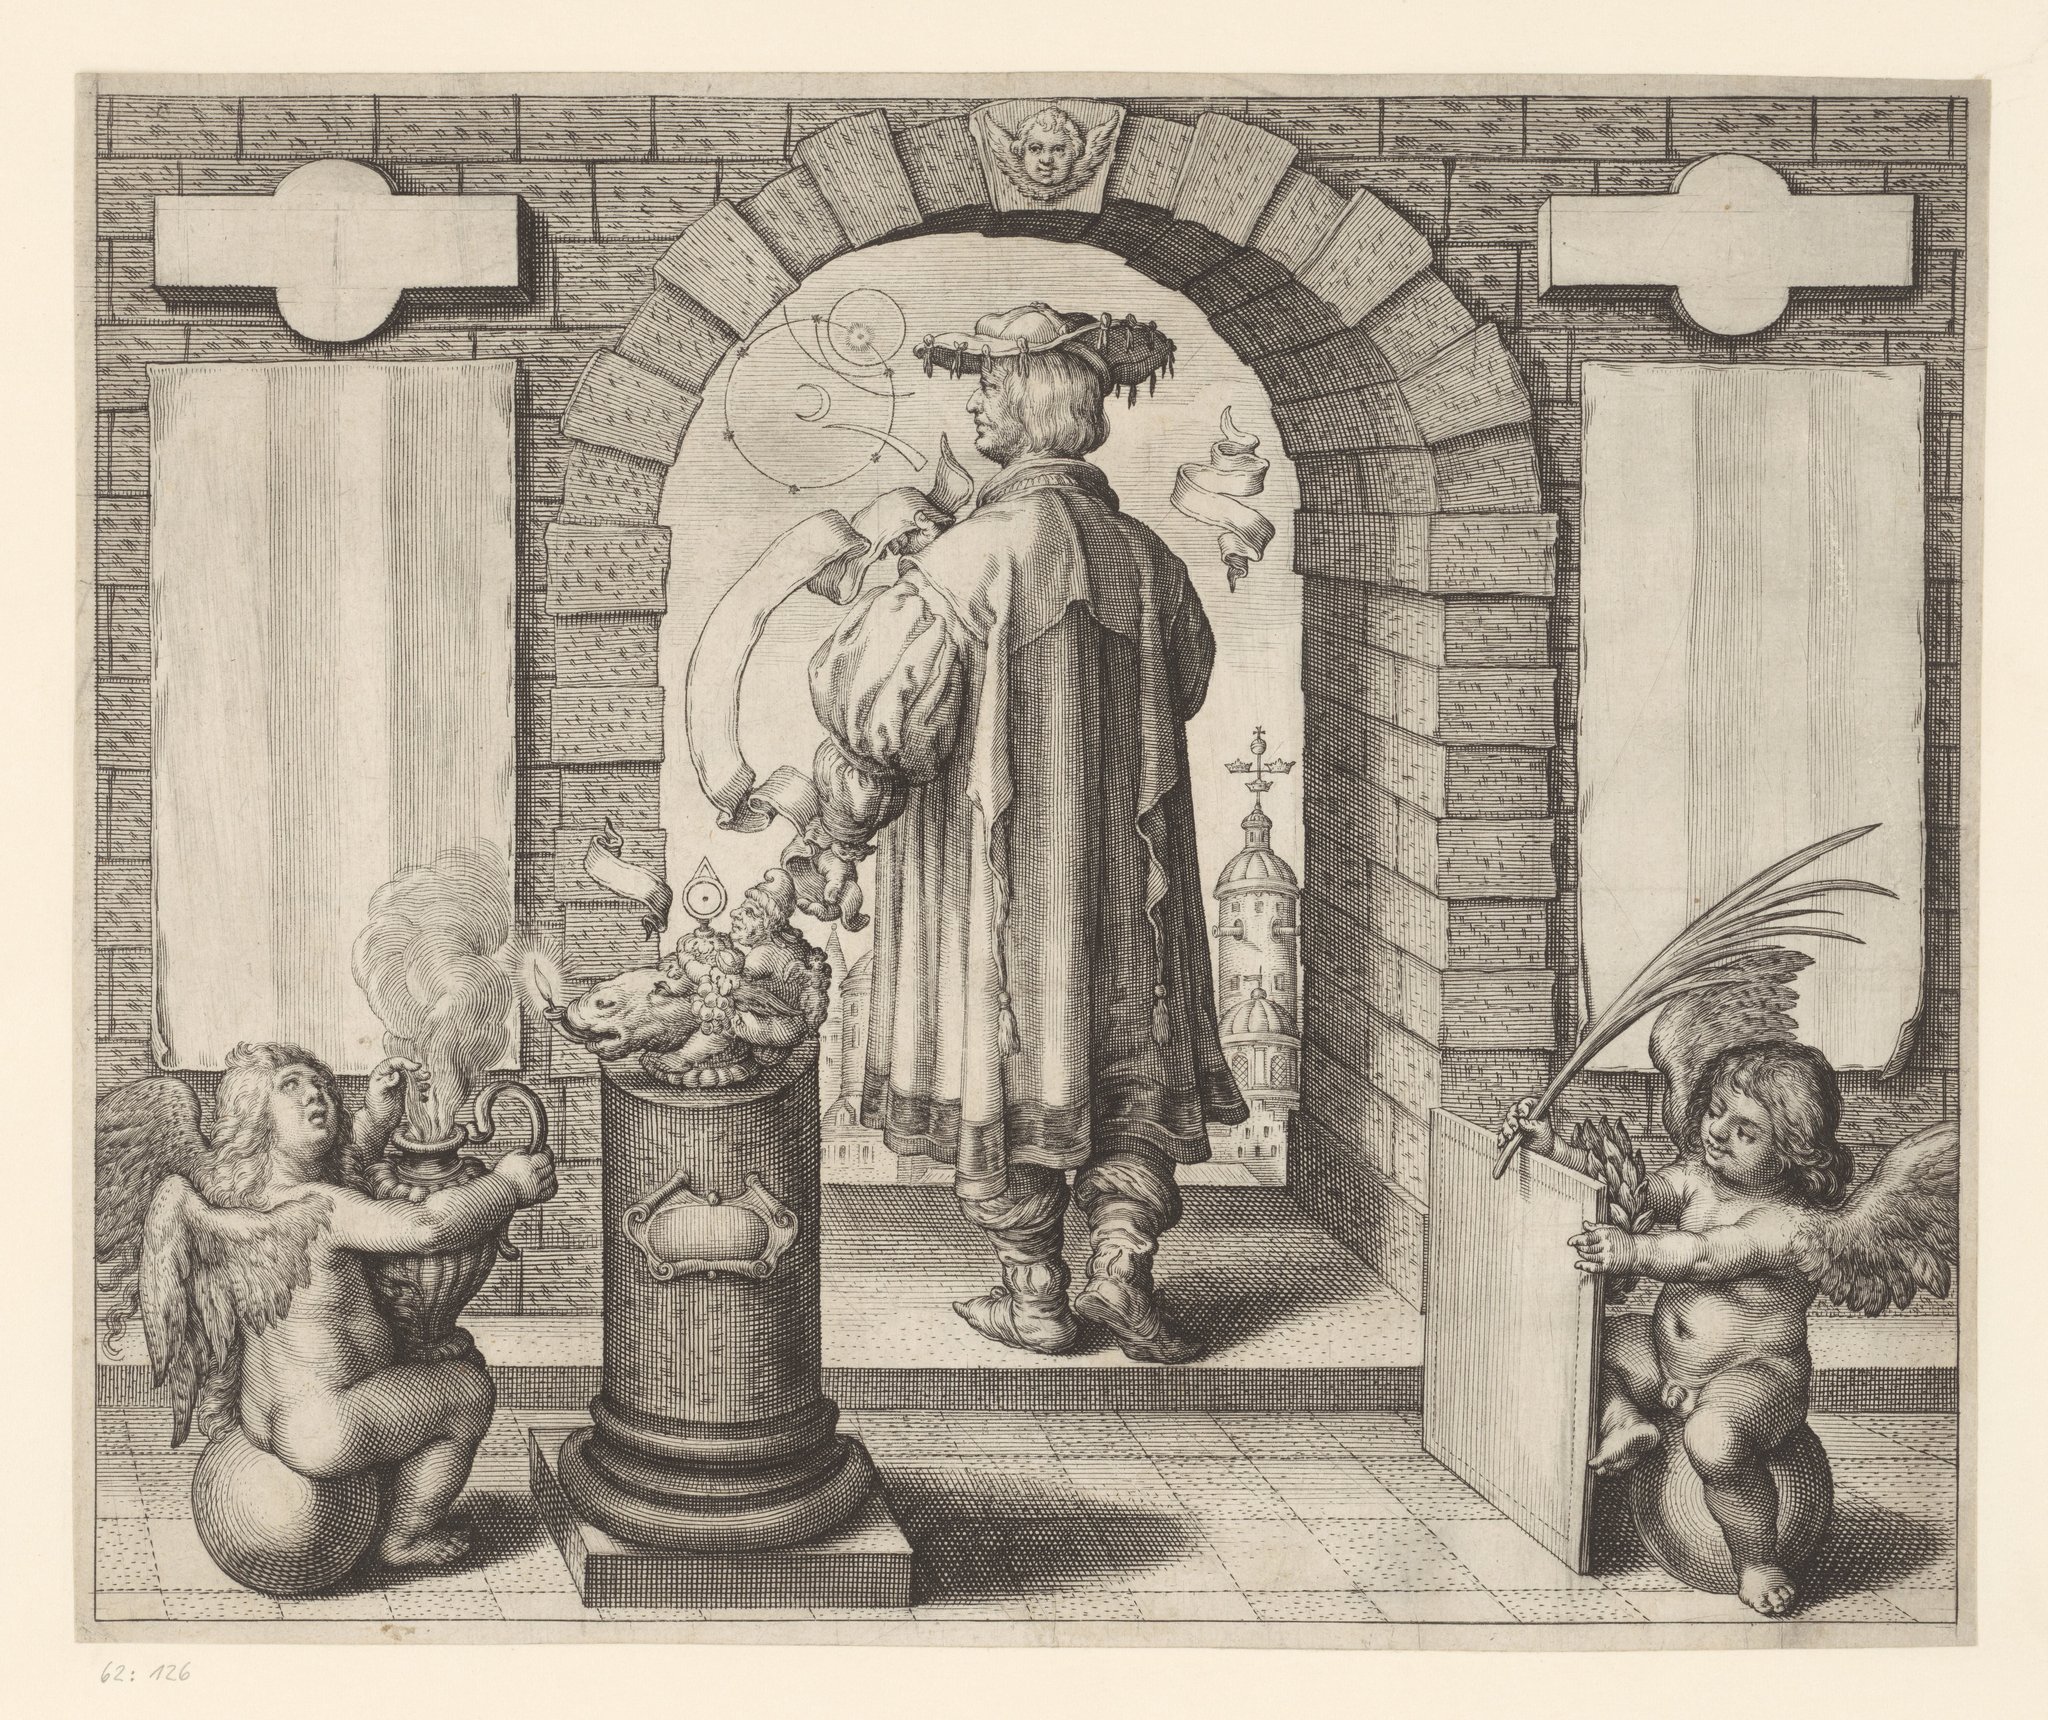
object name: print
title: Allegorische uitbeelding van een zonsverduistering te Stockholm in 1535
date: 1596-1600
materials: paper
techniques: engraving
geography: haarlem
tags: solar eclipse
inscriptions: collector's mark: Lugt 2228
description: Een man staande in een poort, op de rug gezien. Door het portaal een doorkijk naar een stad. In de lucht de zon, maan en sterren. Links een putto met een rokende pot, rechts een putto met palmtak en lauwerkrans.